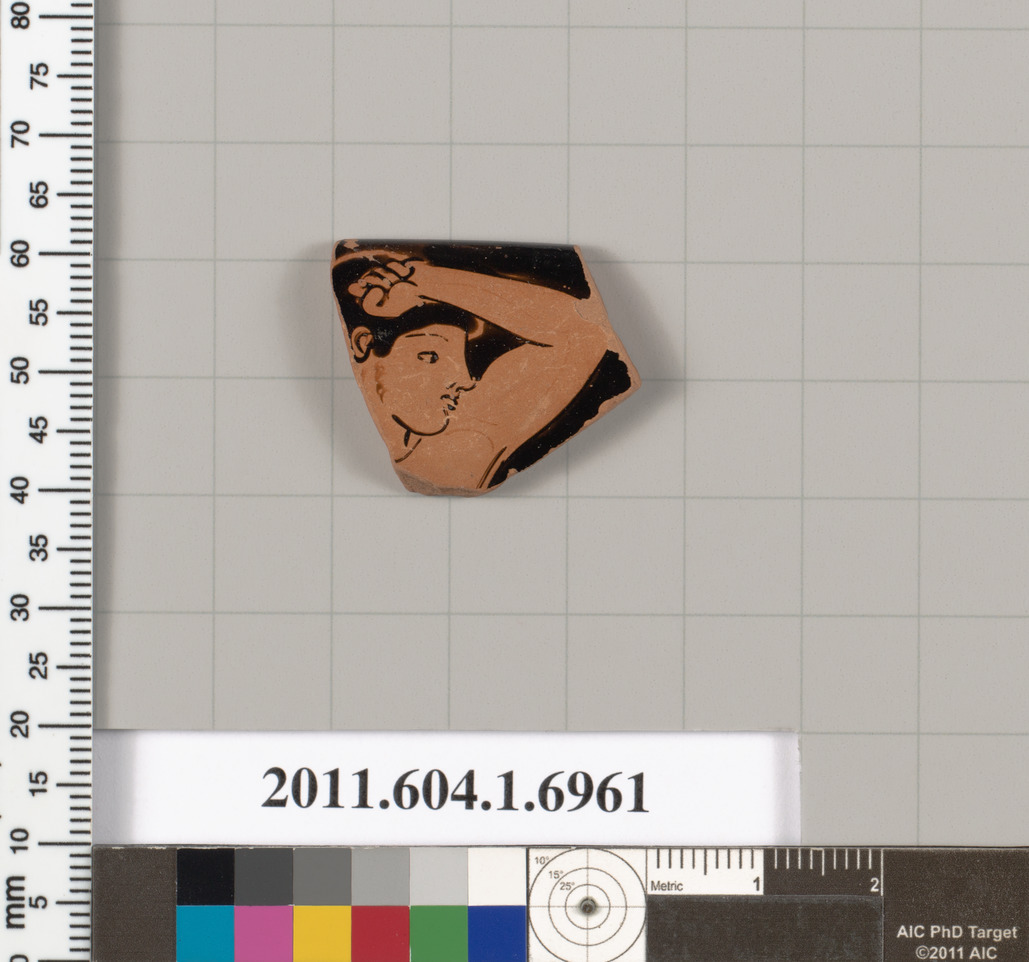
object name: kylix fragment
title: Terracotta rim fragment of a kylix (drinking cup)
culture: greek, attic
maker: painter of the paris gigantomachy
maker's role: artist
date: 480-470 BCE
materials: terracotta